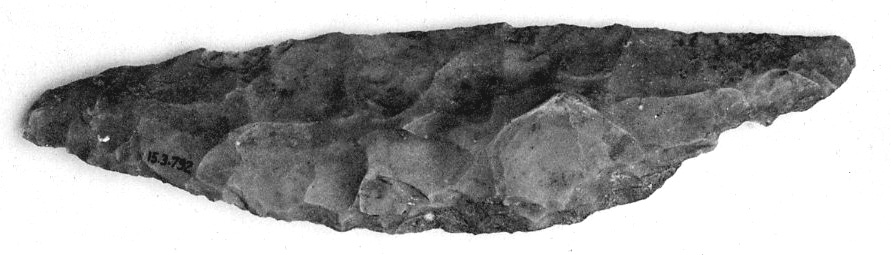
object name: knife, bifacial knife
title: Bifacial knife with handle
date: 1295-712 BCE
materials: stone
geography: egypt